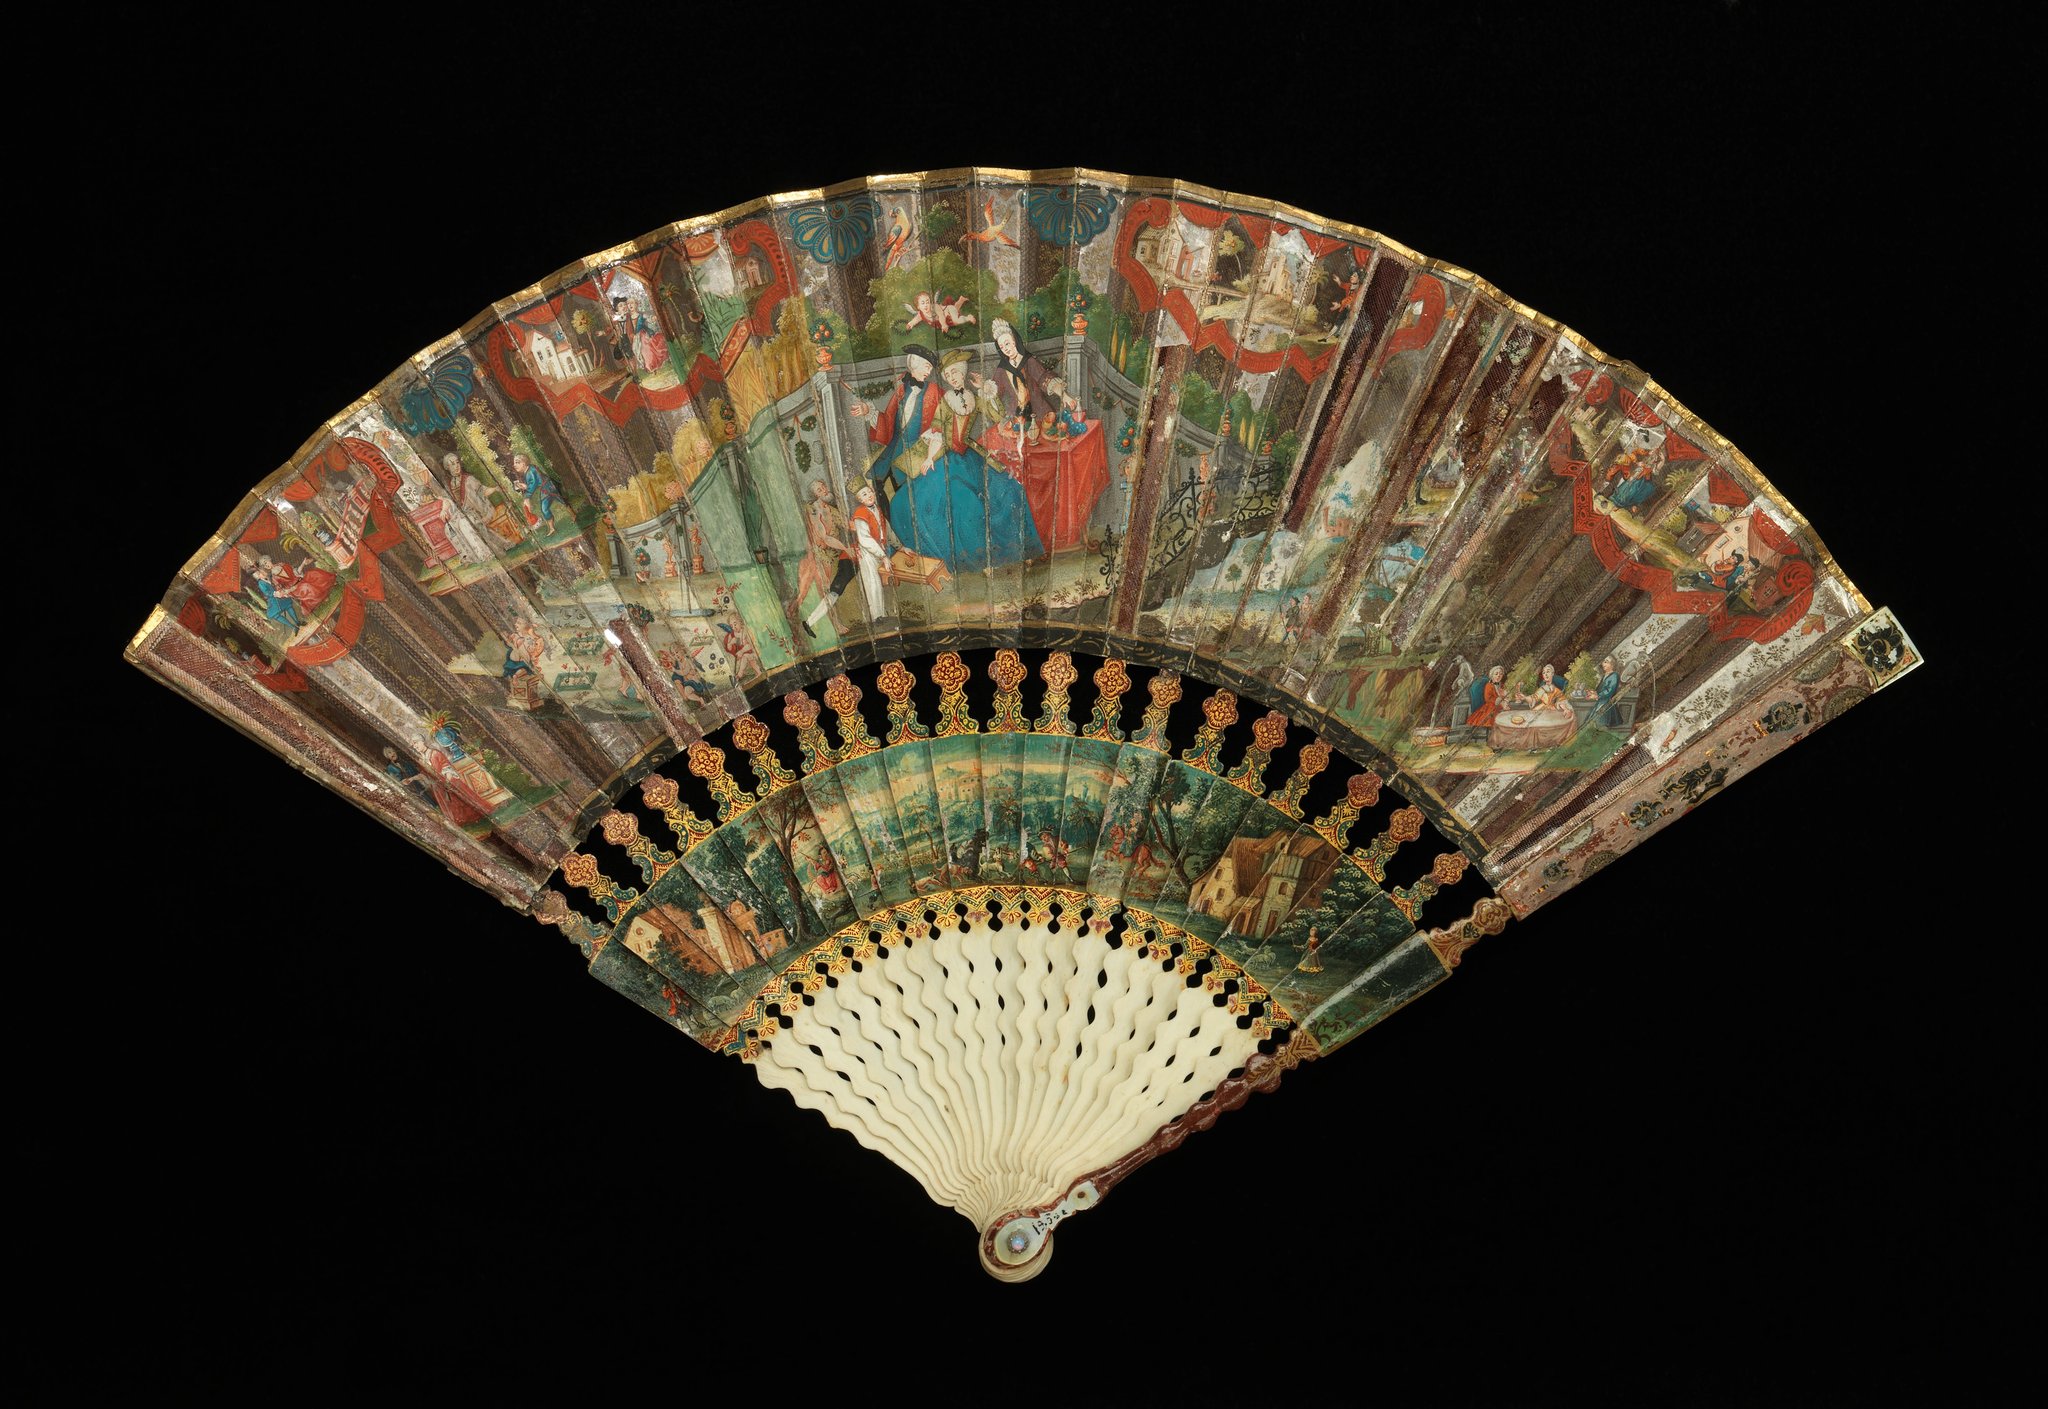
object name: fan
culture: european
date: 1730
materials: gouache, ivory, mother of pearl, oil, paper, silk, wood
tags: birds,men,women,putti,dogs